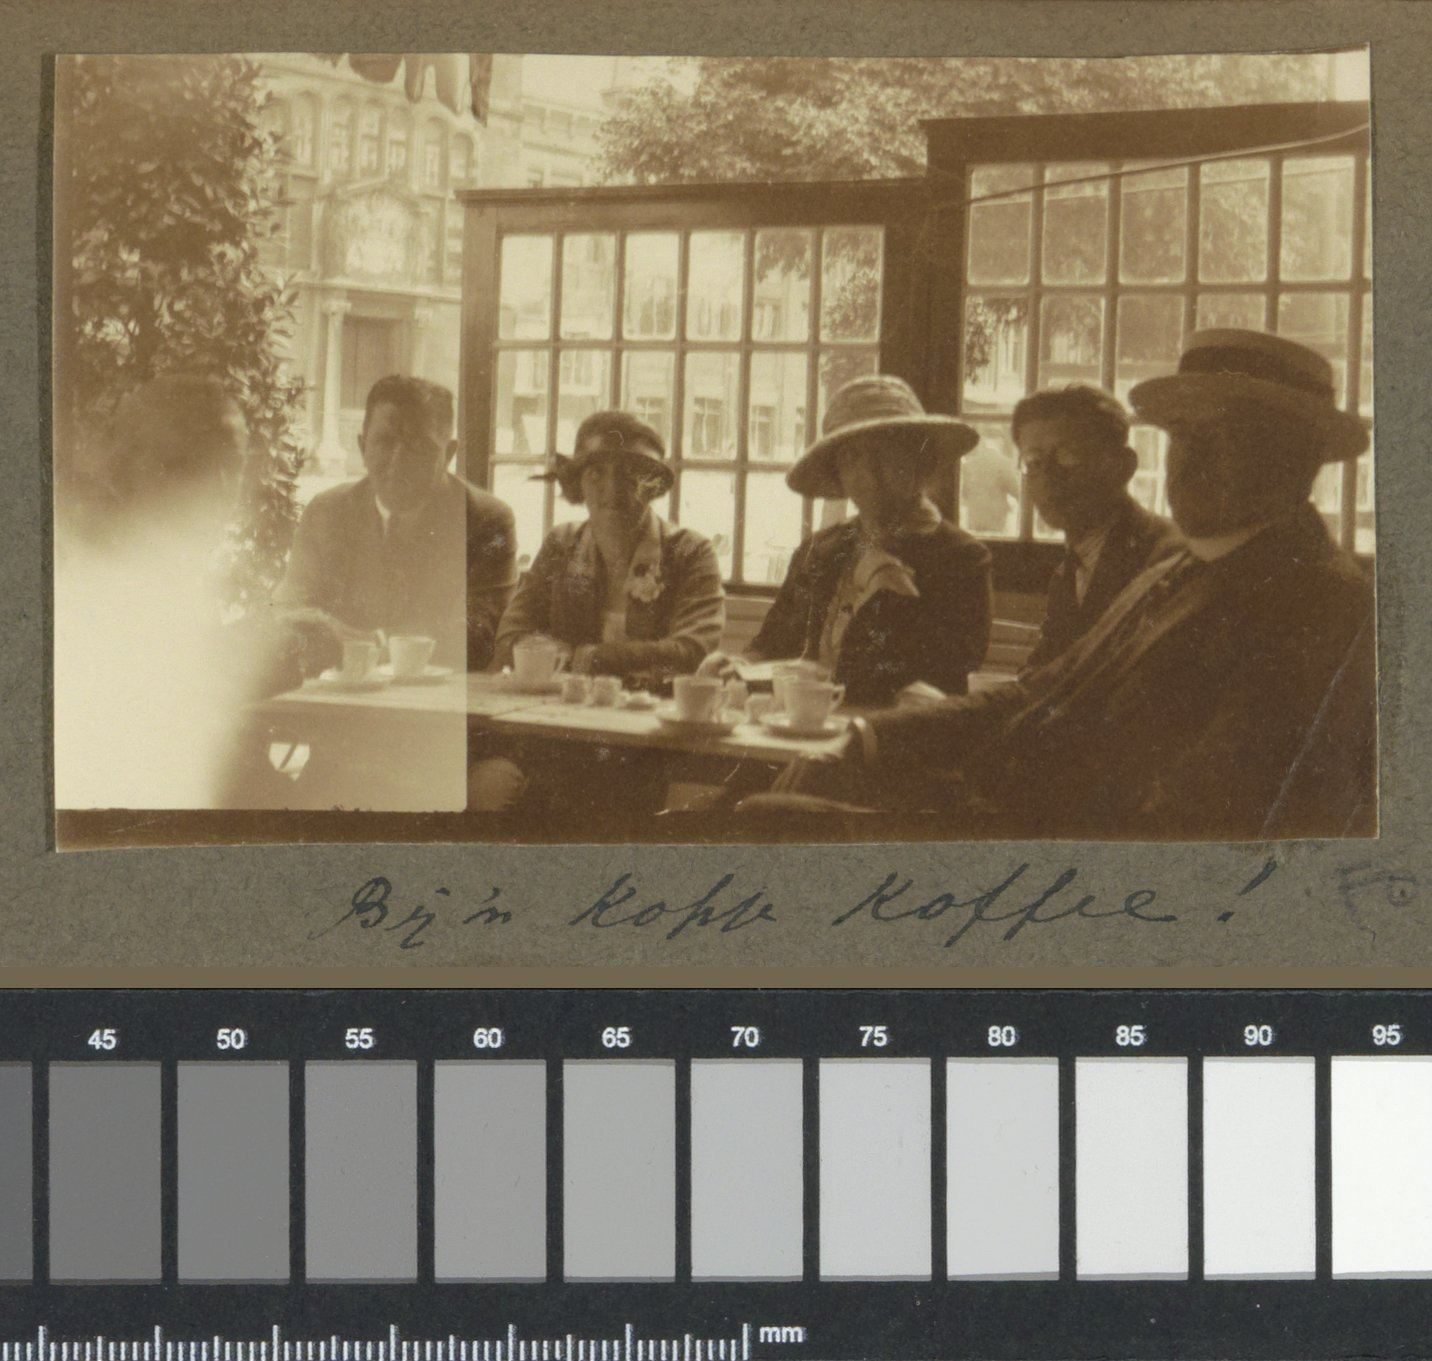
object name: photograph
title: Bij 'n kopje koffie!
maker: Anonymous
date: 1906-1924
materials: photographic support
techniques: gelatin silver print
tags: adult woman, adult man, drinking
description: Onderdeel van fotoalbum van een onbekende Nederlandse familie met opnames van Suriname, Europa en Nederlands-Indië.